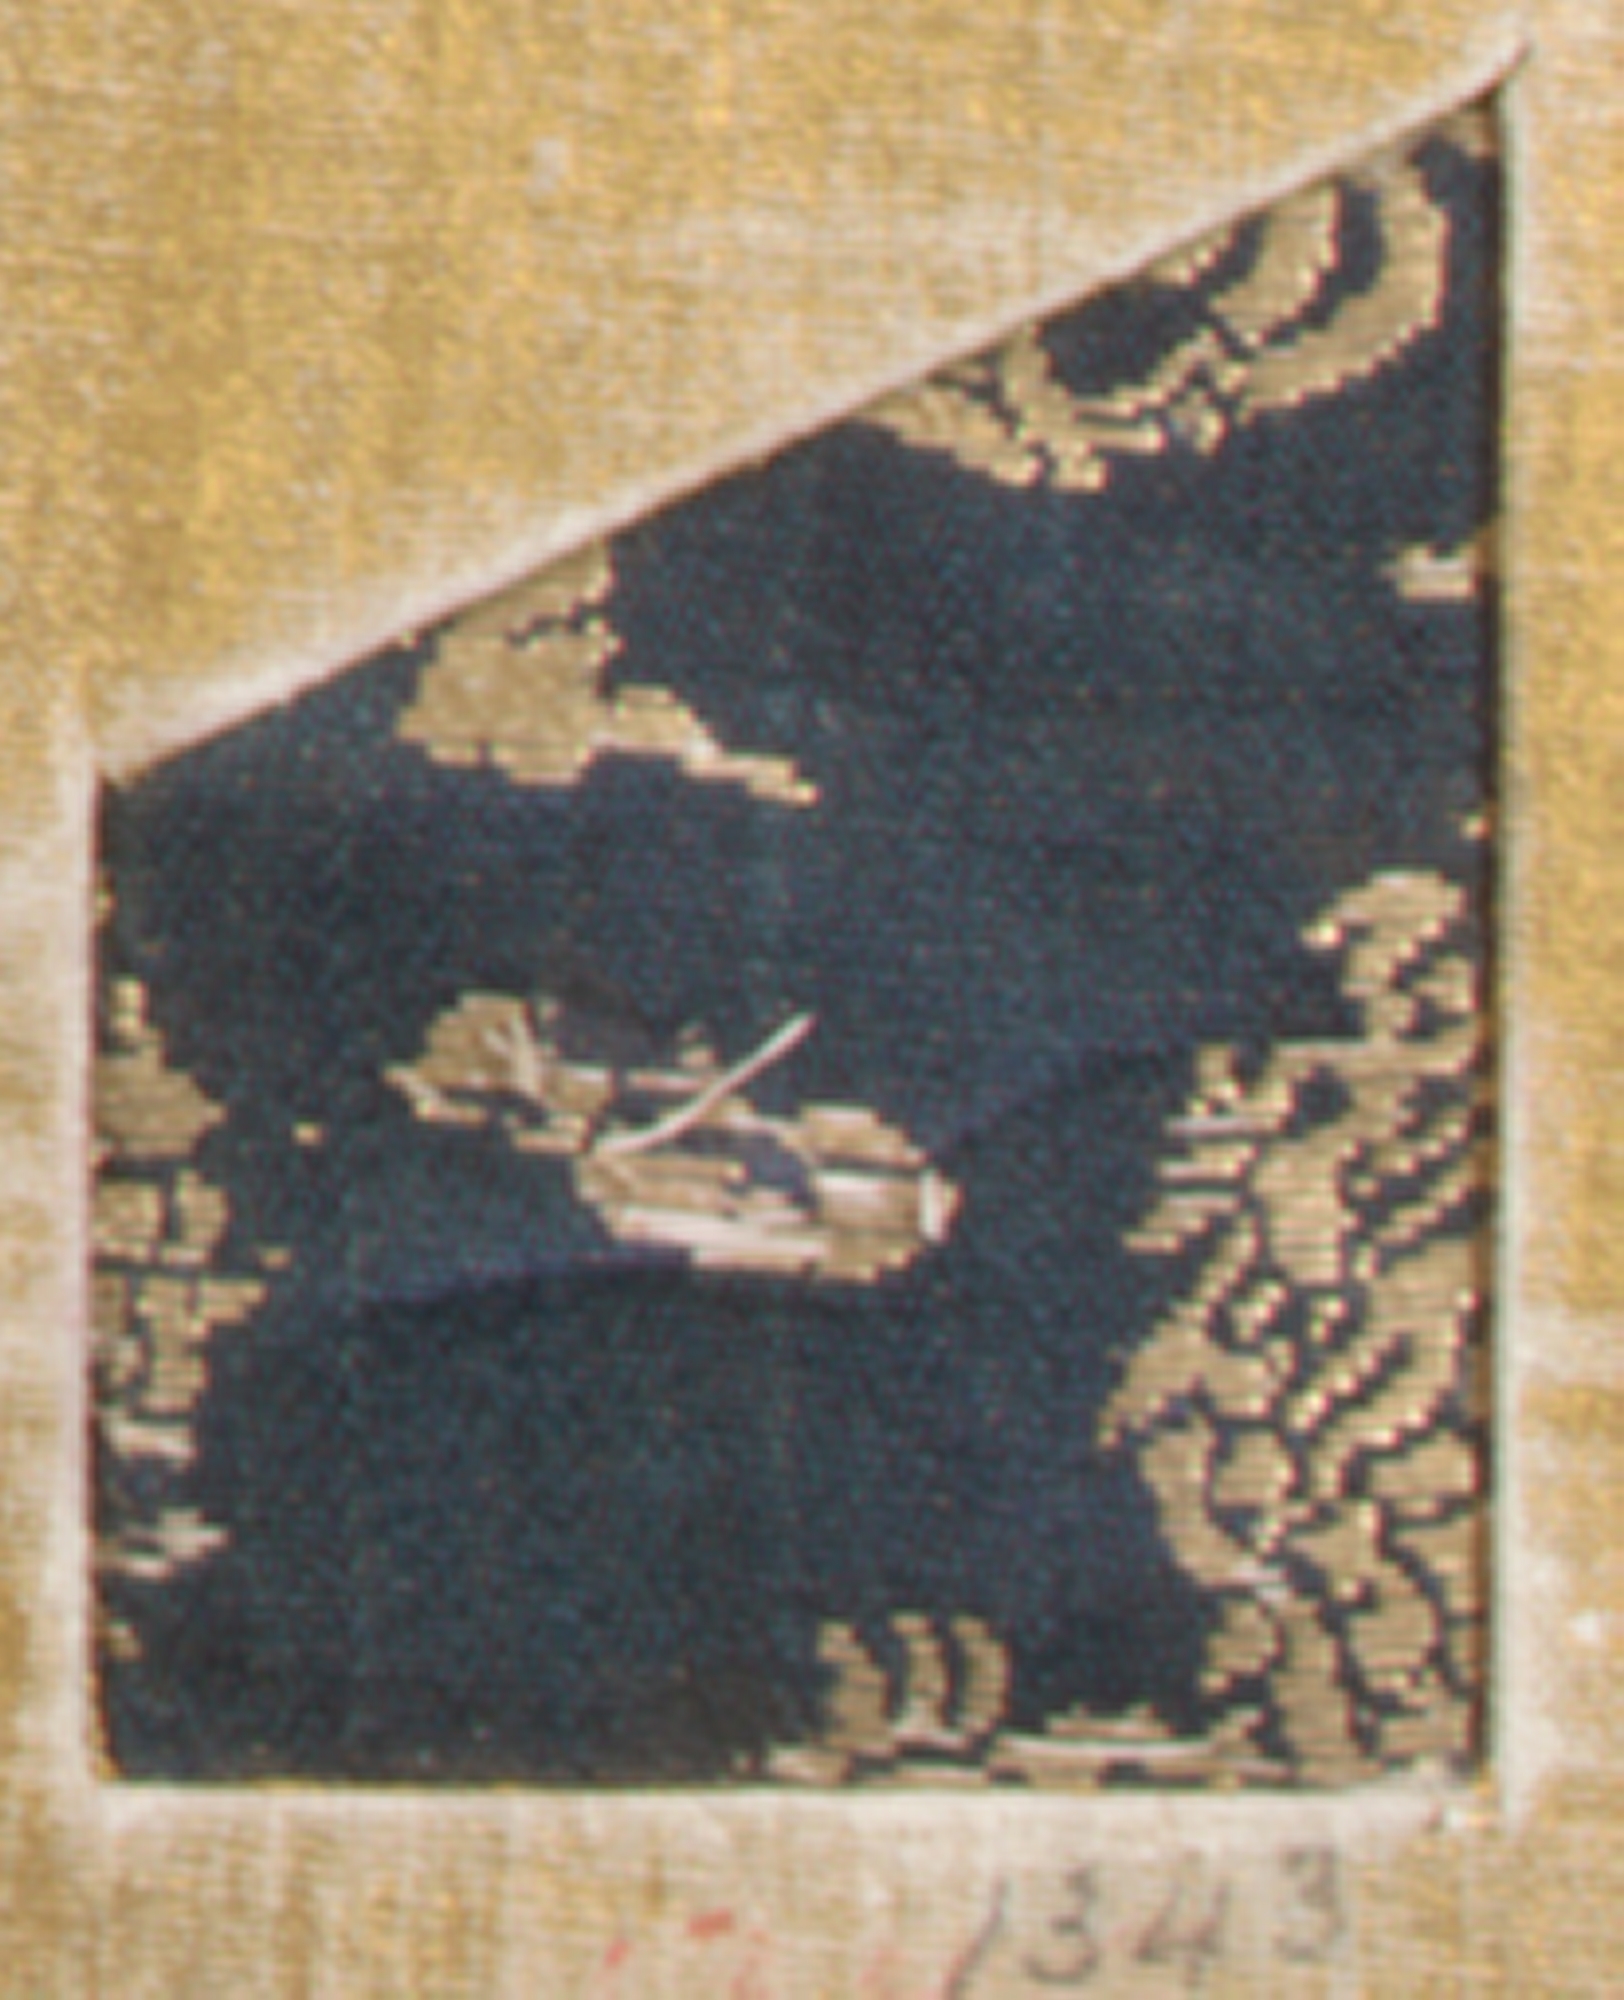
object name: piece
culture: japanese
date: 1701-1900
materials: silk